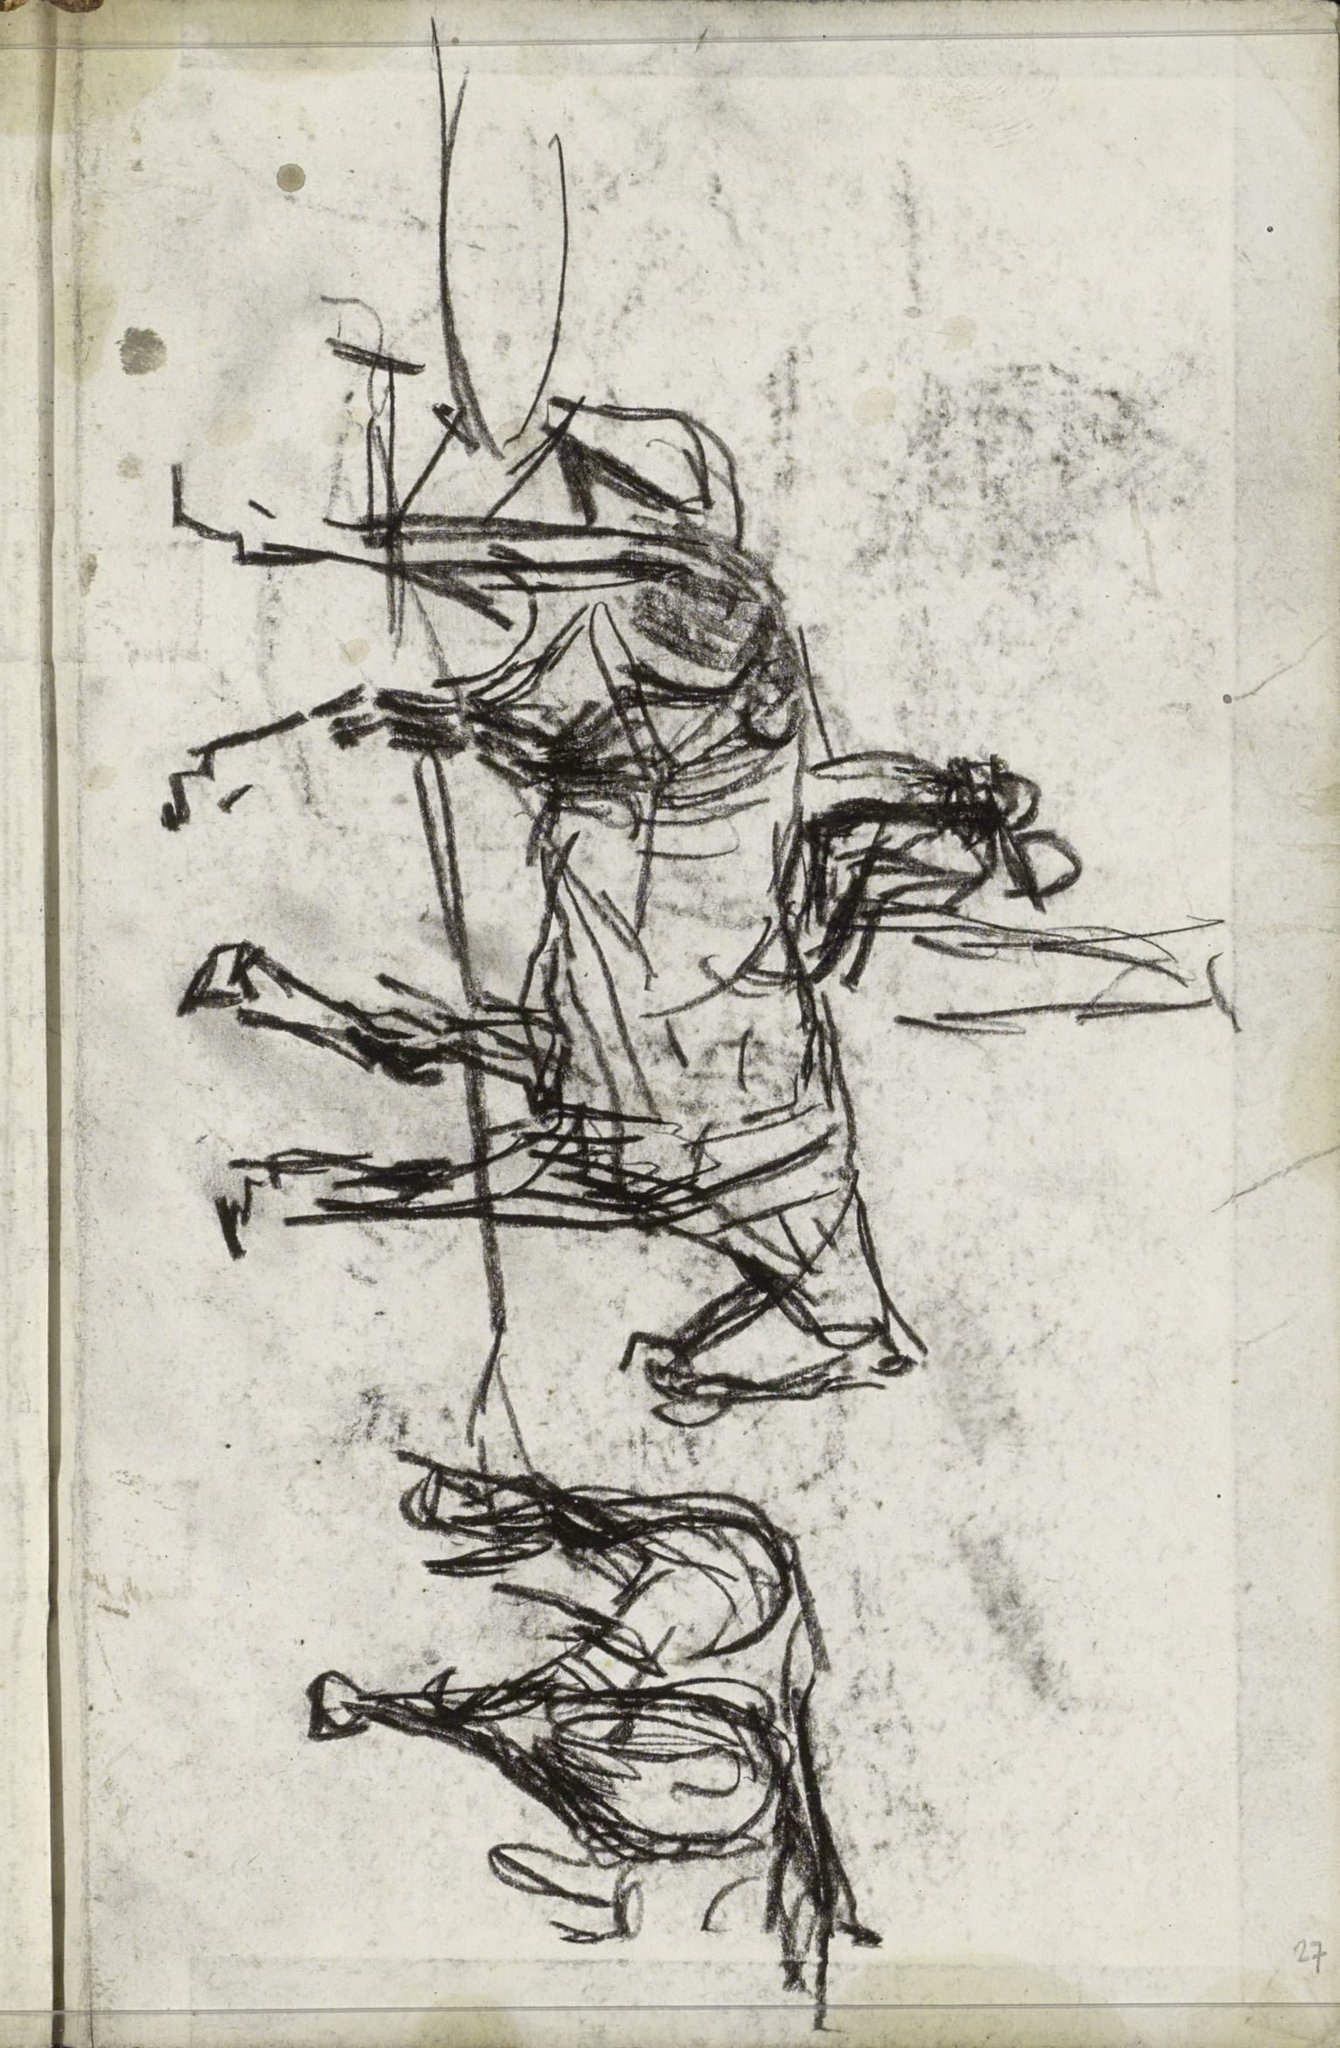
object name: endleaf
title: Vier aangespannen paarden met twee ruiters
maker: isaac israels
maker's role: draughtsman, painter, print maker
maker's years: 1865-1934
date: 1875-1934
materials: chalk, paper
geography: london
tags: adult man (+ sitting), horse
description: Schutblad B, achterste schutblad, uit schetsboek XXXVI met 26 bladen.